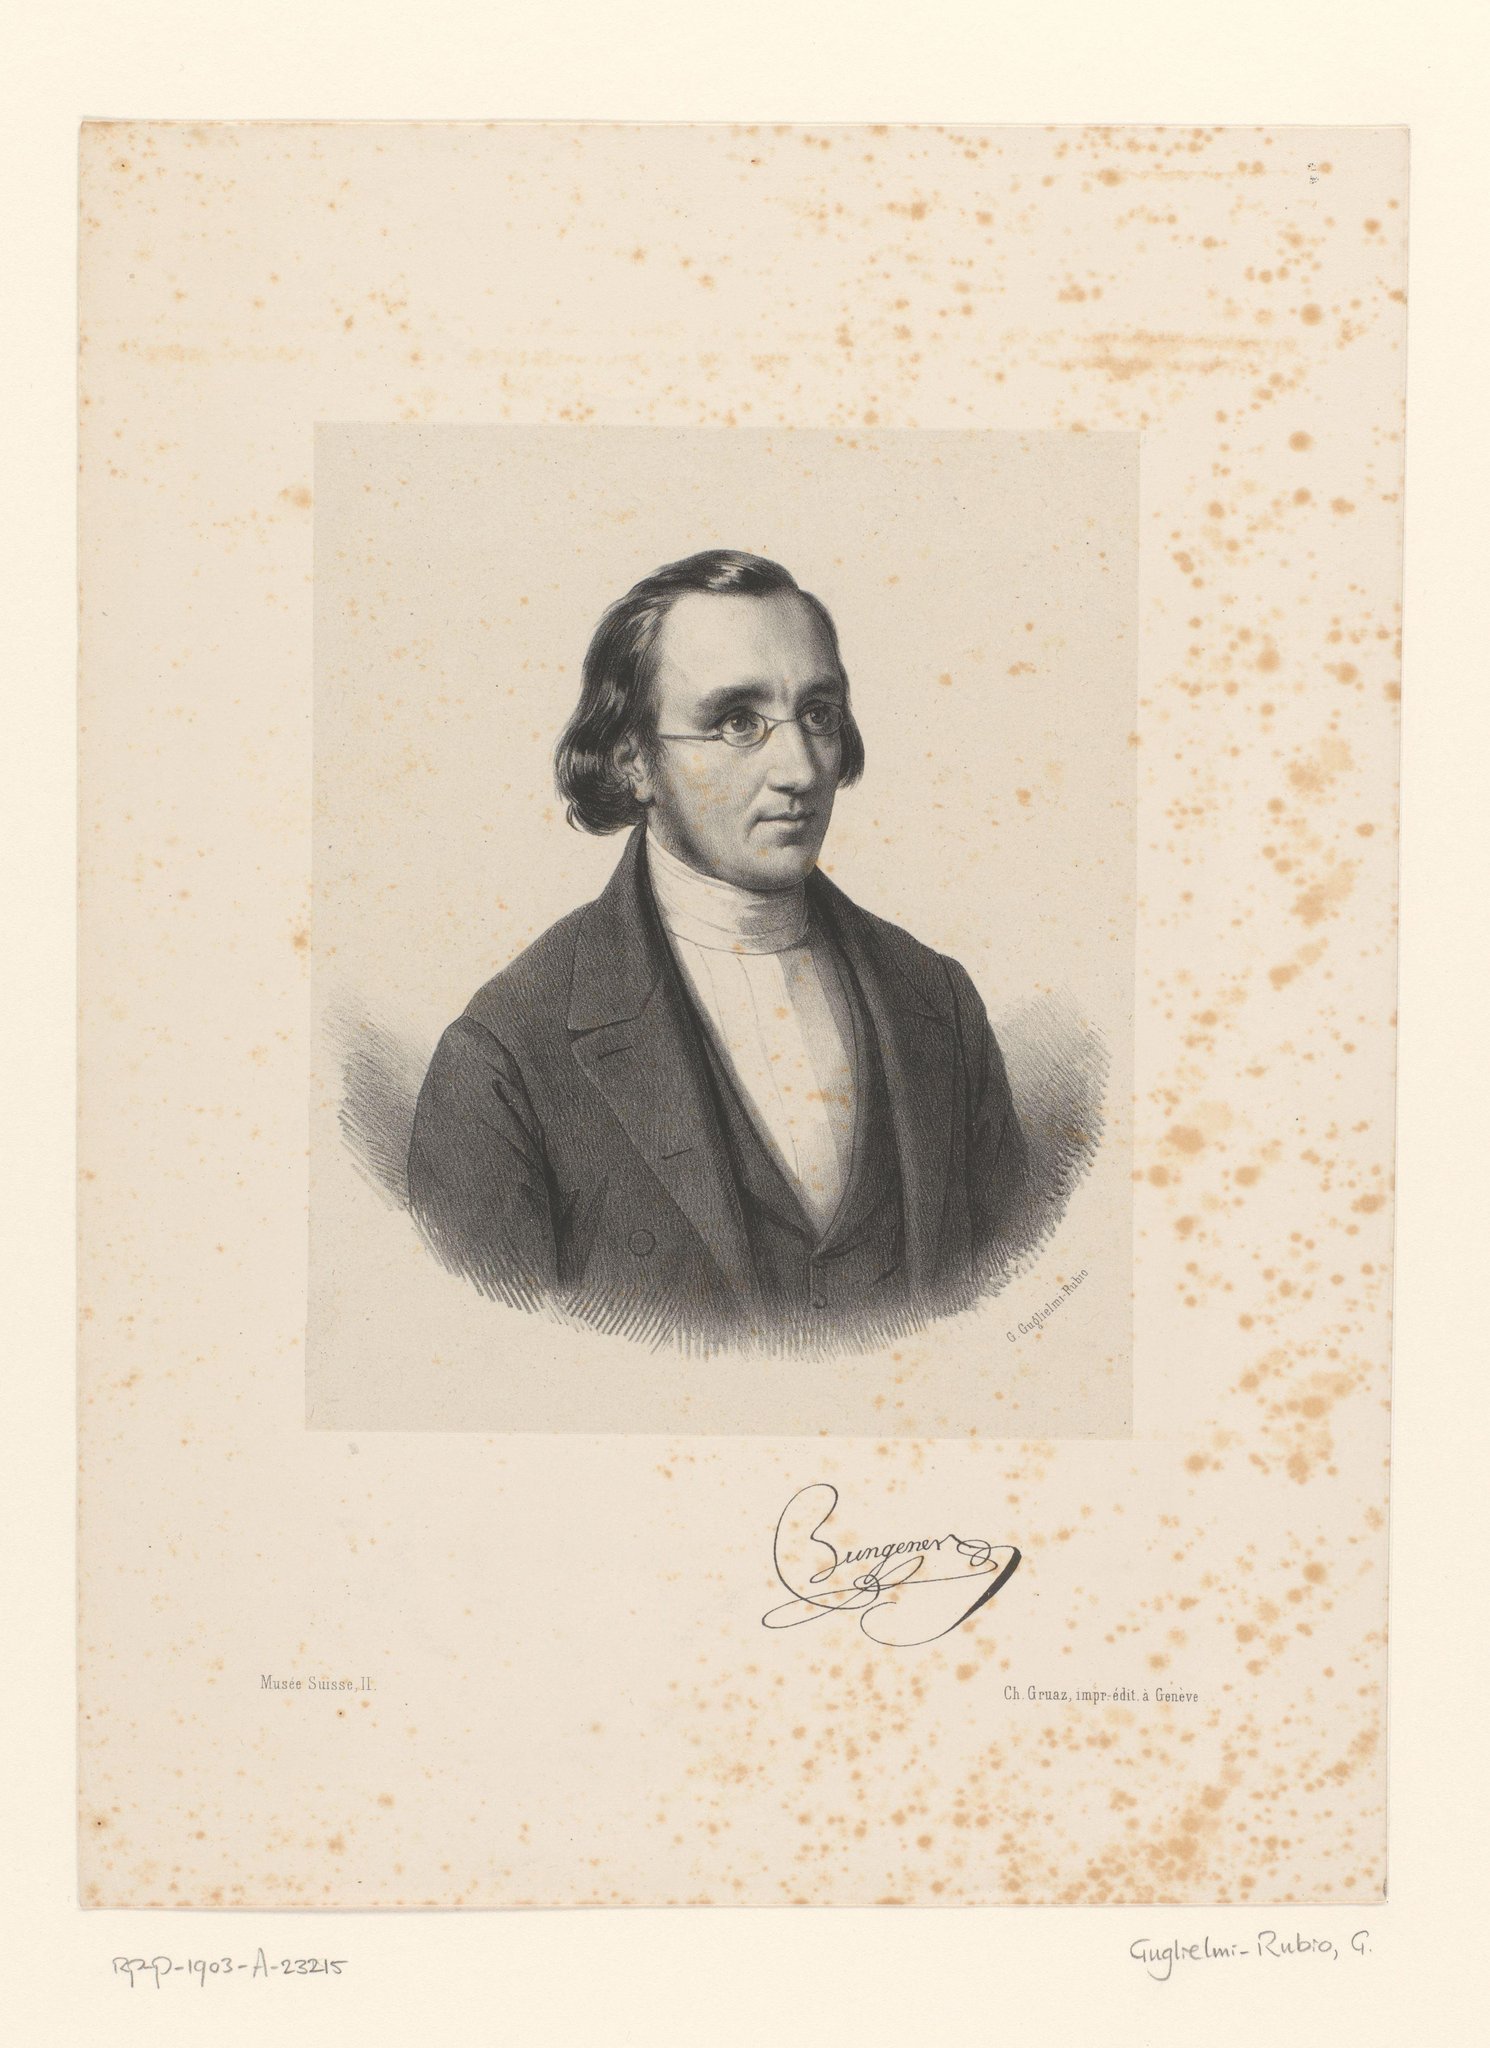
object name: print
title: Portret van de heer Bungener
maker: g. guglielmi-rubio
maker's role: print maker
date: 1853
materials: paper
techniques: lithograph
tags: eyeglasses, spectacles, historical persons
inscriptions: collector's mark: Lugt 2228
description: Deze prent maakt deel uit van een set getiteld: Musée Suisse, II.